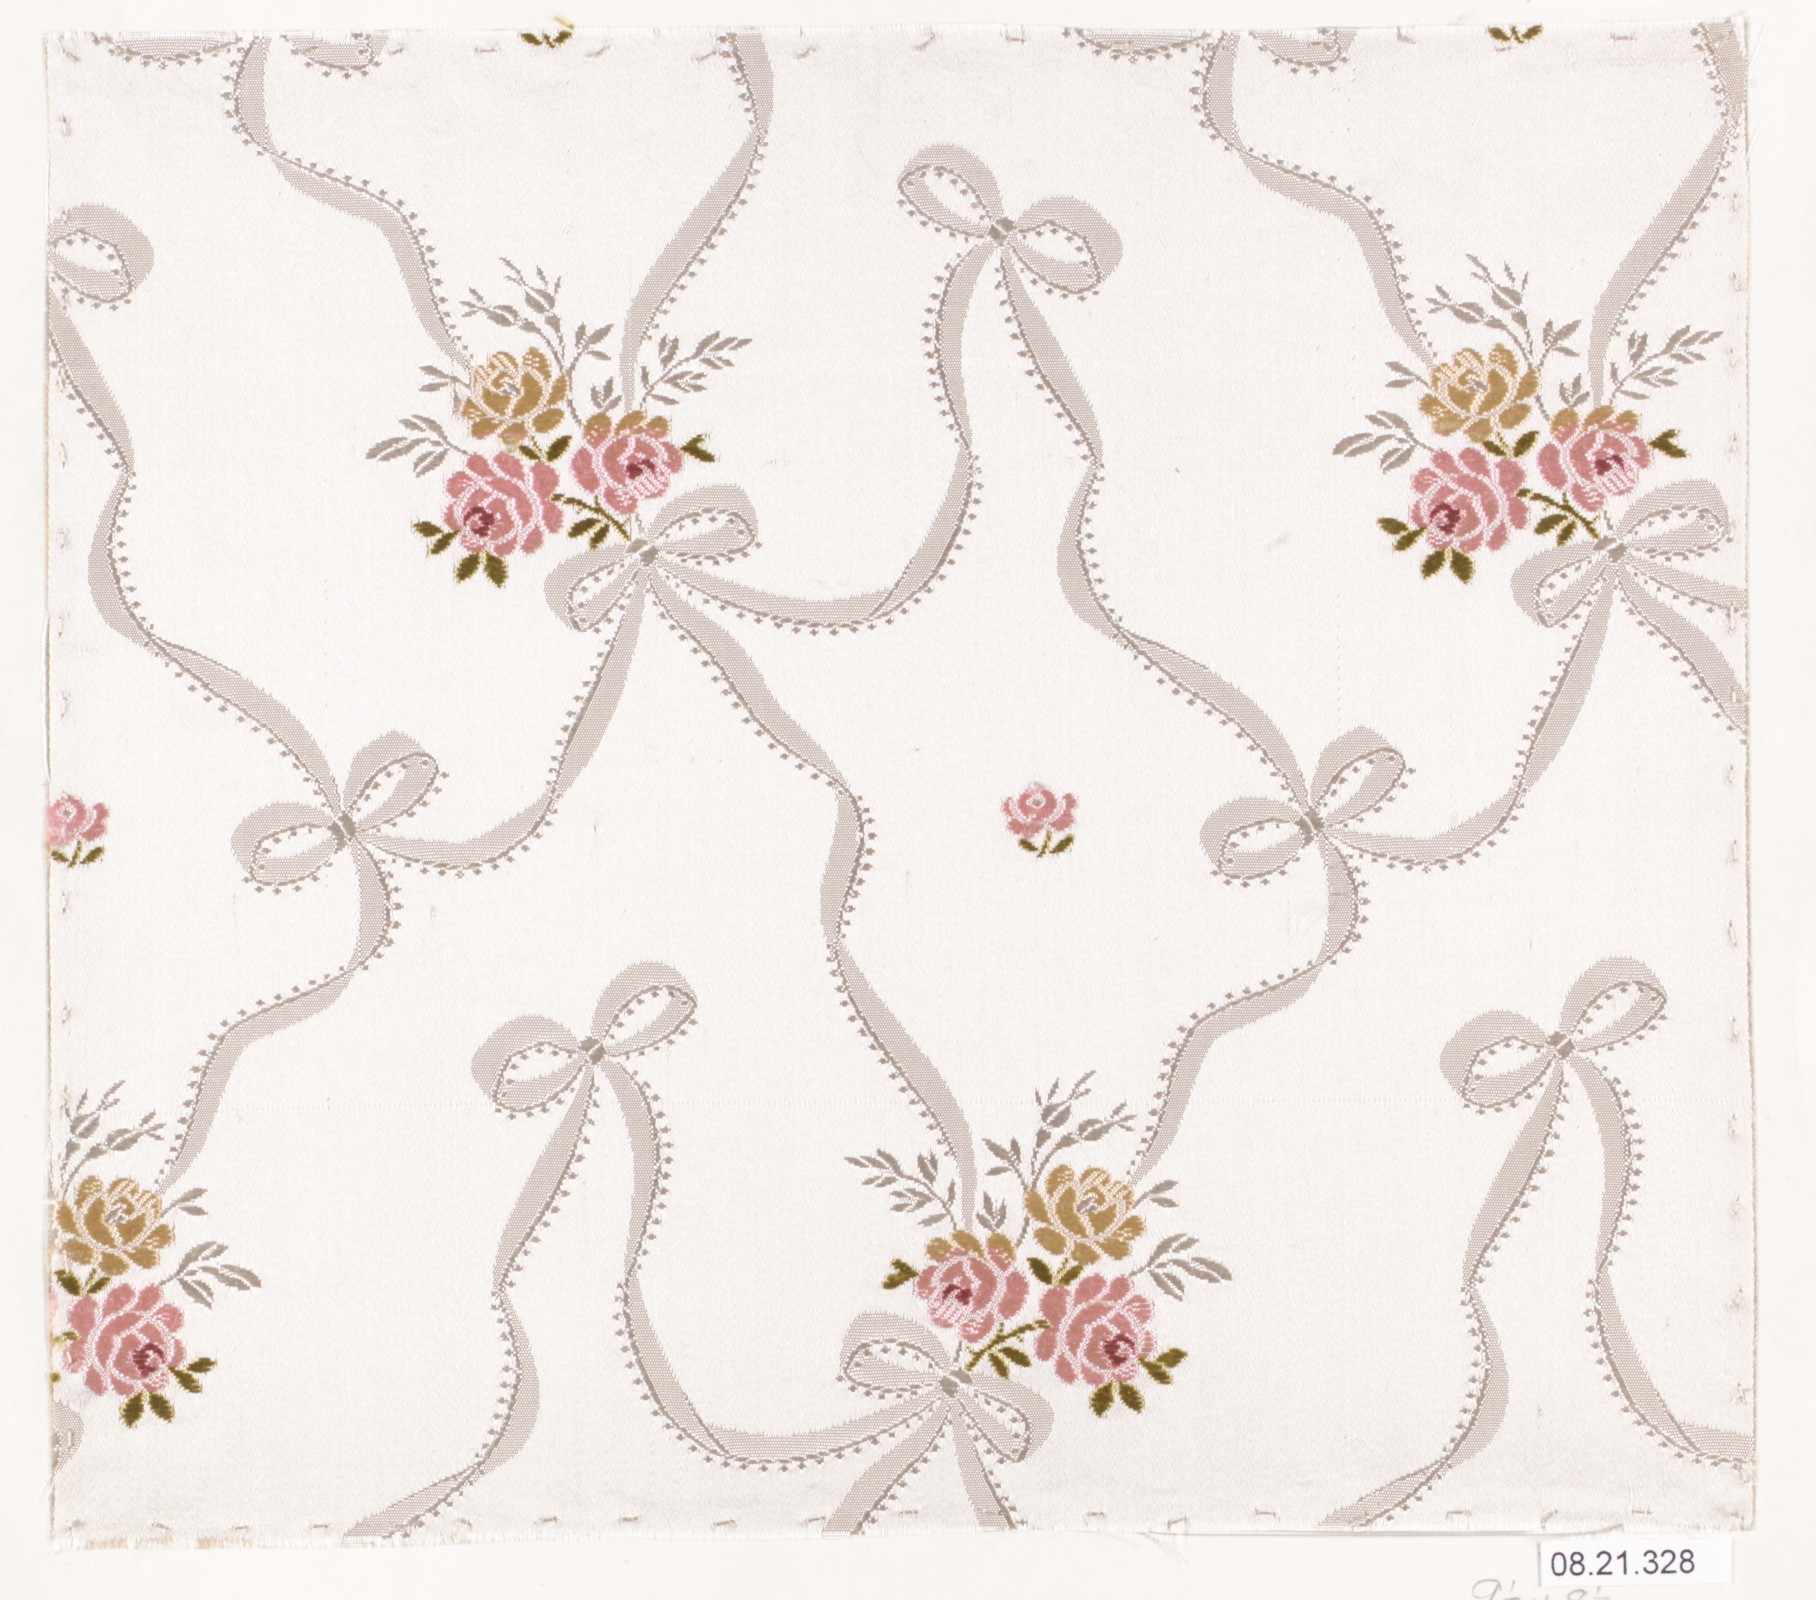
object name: textile sample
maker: Anonymous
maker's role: designer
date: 1900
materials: silk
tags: flowers